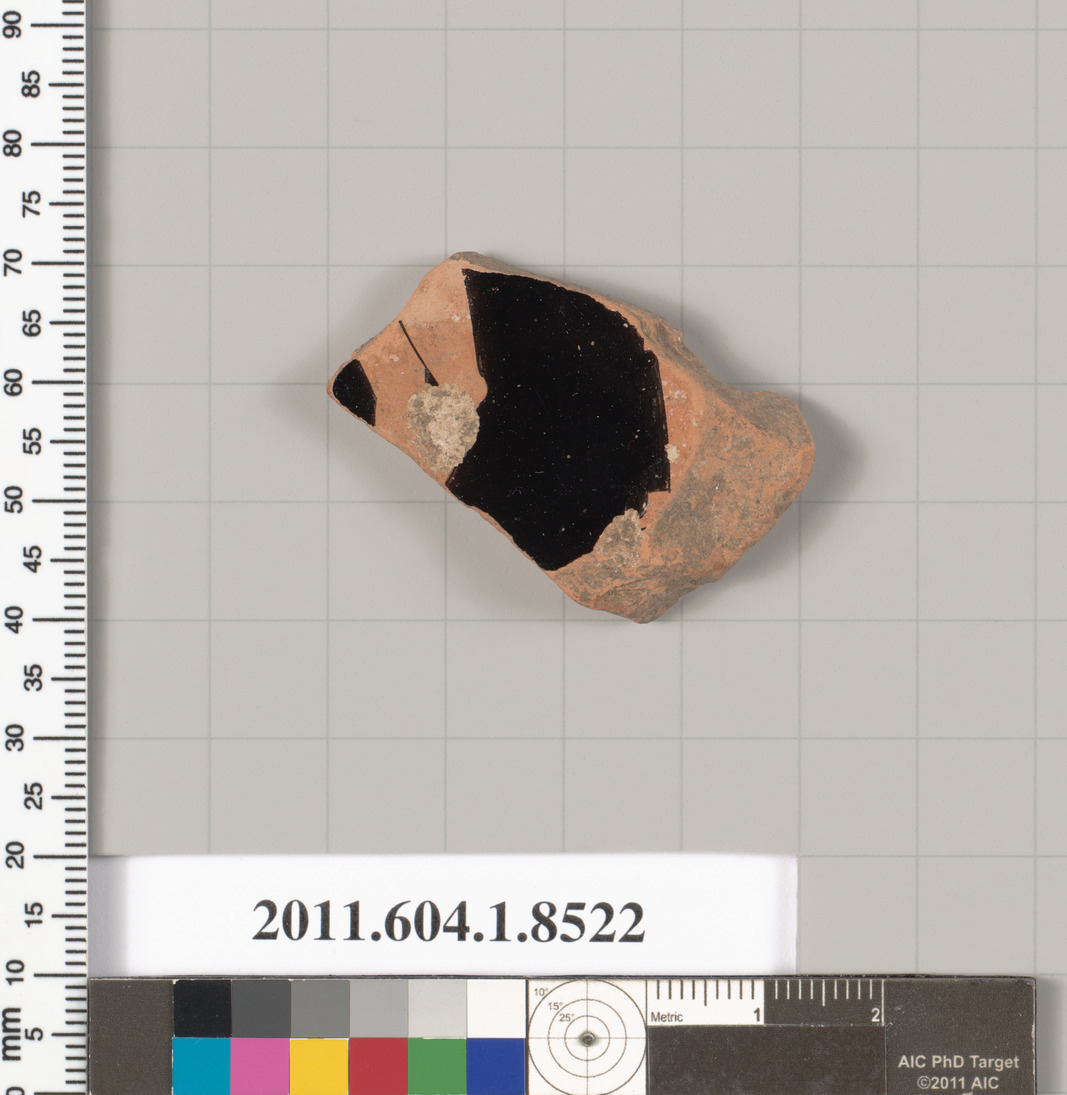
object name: kylix fragment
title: Terracotta fragment of a stemless kylix (drinking cup)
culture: greek, attic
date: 475-451 BCE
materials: terracotta